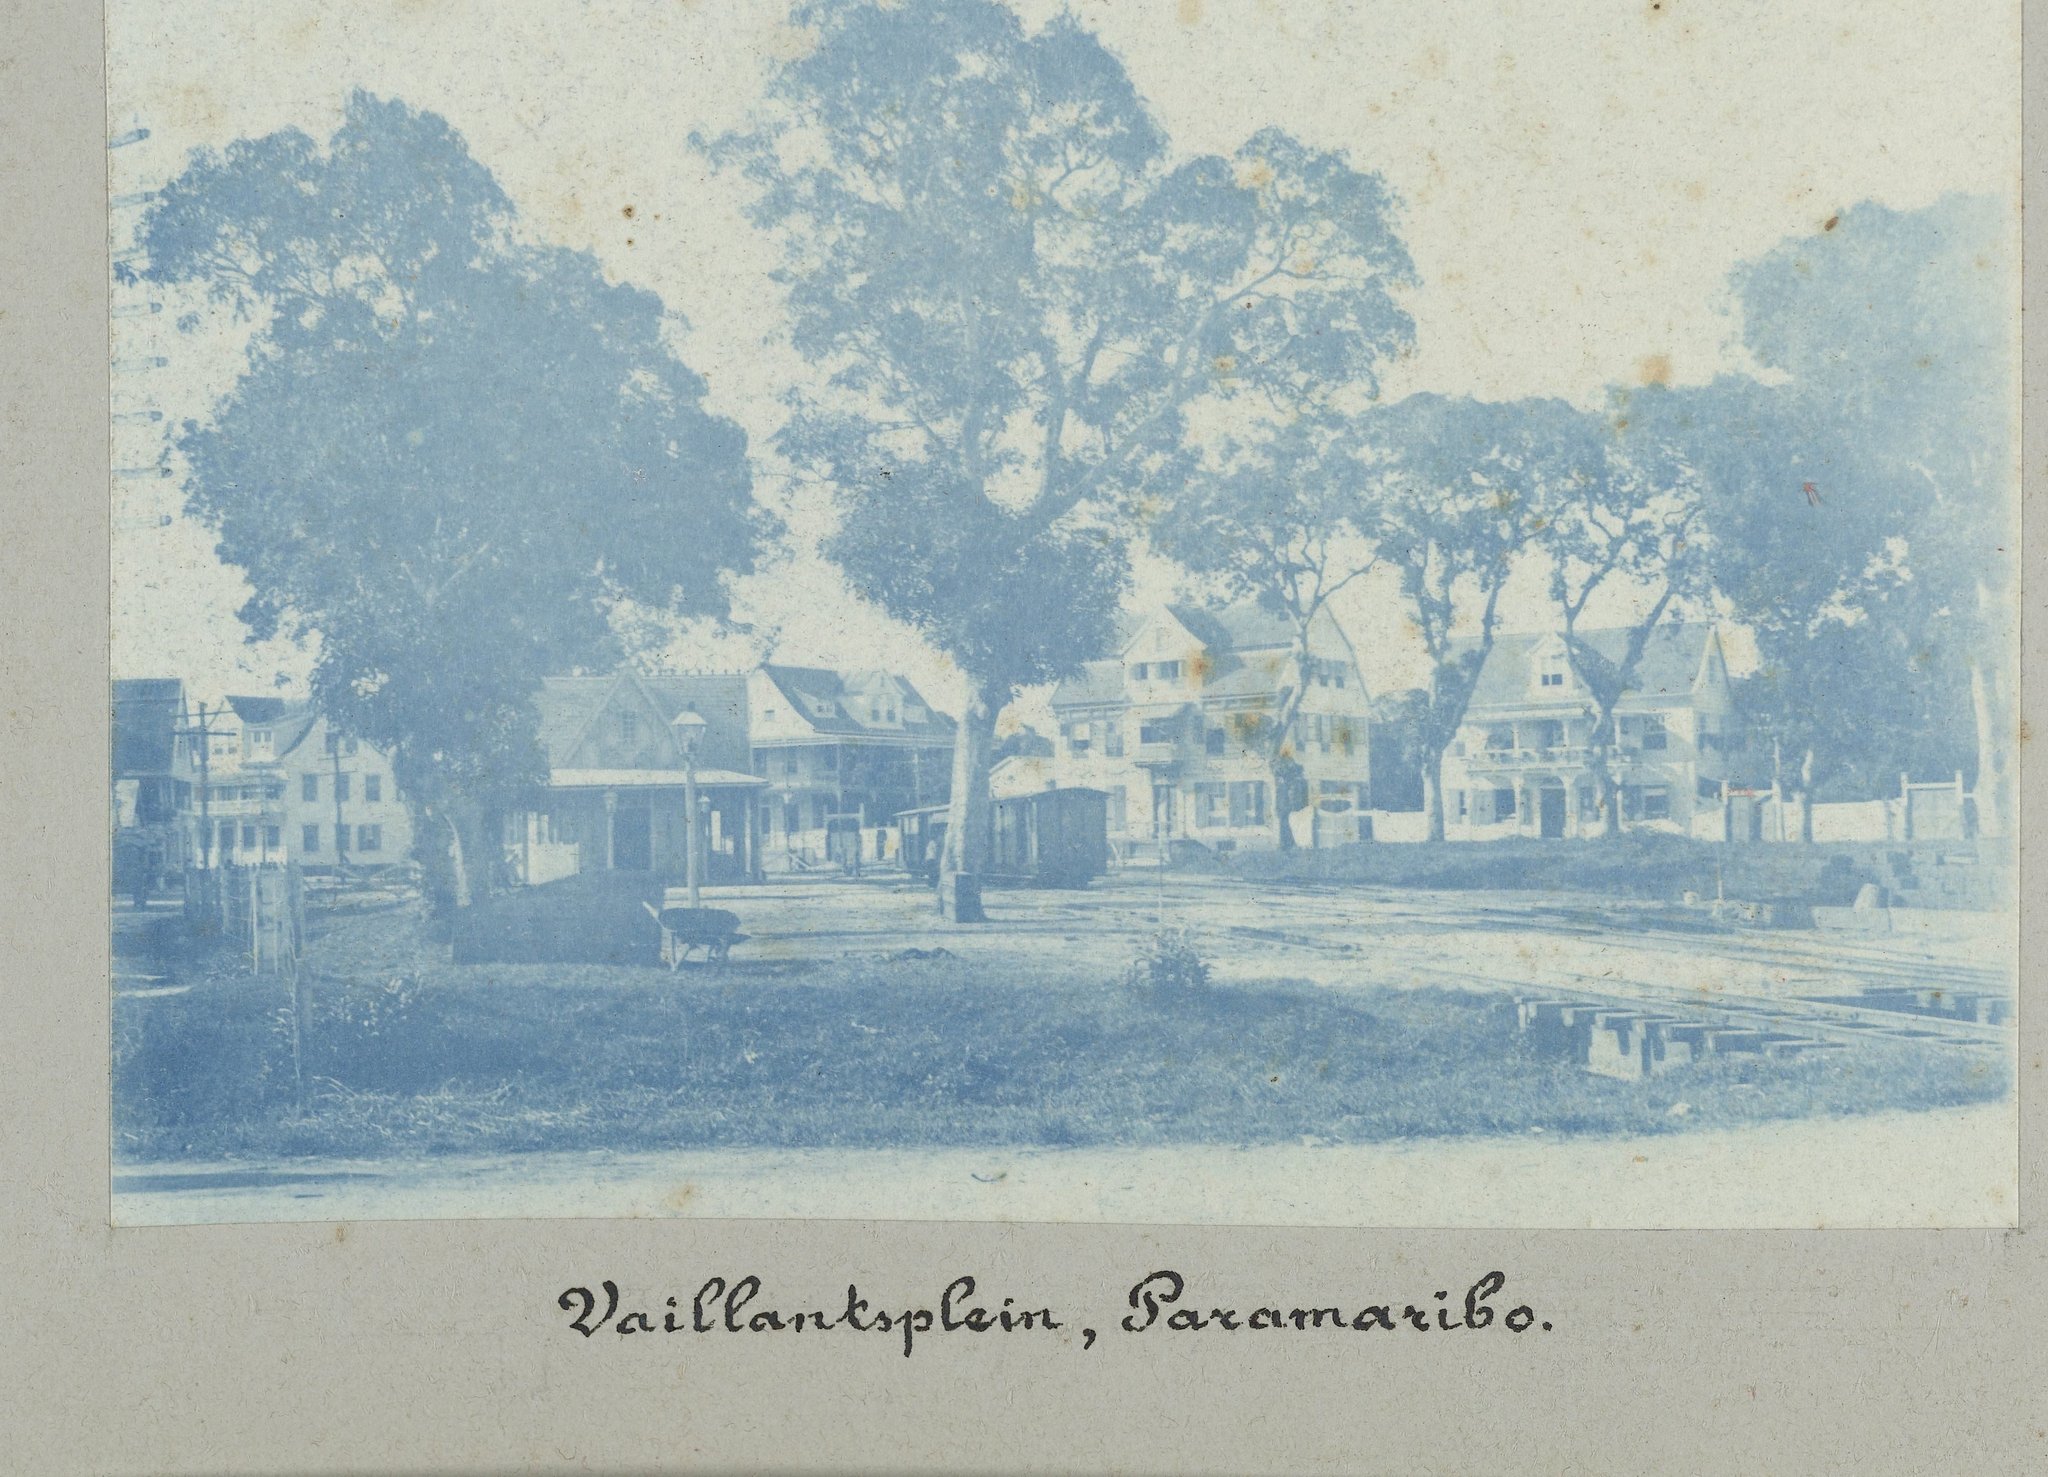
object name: photograph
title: Vaillantsplein, Paramaribo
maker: hendrik doijer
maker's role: engineer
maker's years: 1863-1925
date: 1903-1910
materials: photographic support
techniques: cyanotype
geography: suriname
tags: suriname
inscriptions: inscription: ‘111. / Vaillantsplein, Paramaribo.’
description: Gezicht op de huizen op Vaillantsplein te Paramaribo. Onderdeel van het fotoalbum Souvenir de Voyage (deel 1), over het leven van de familie Doijer in en rond de plantage Ma Retraite in Suriname in de jaren 1903-1910.